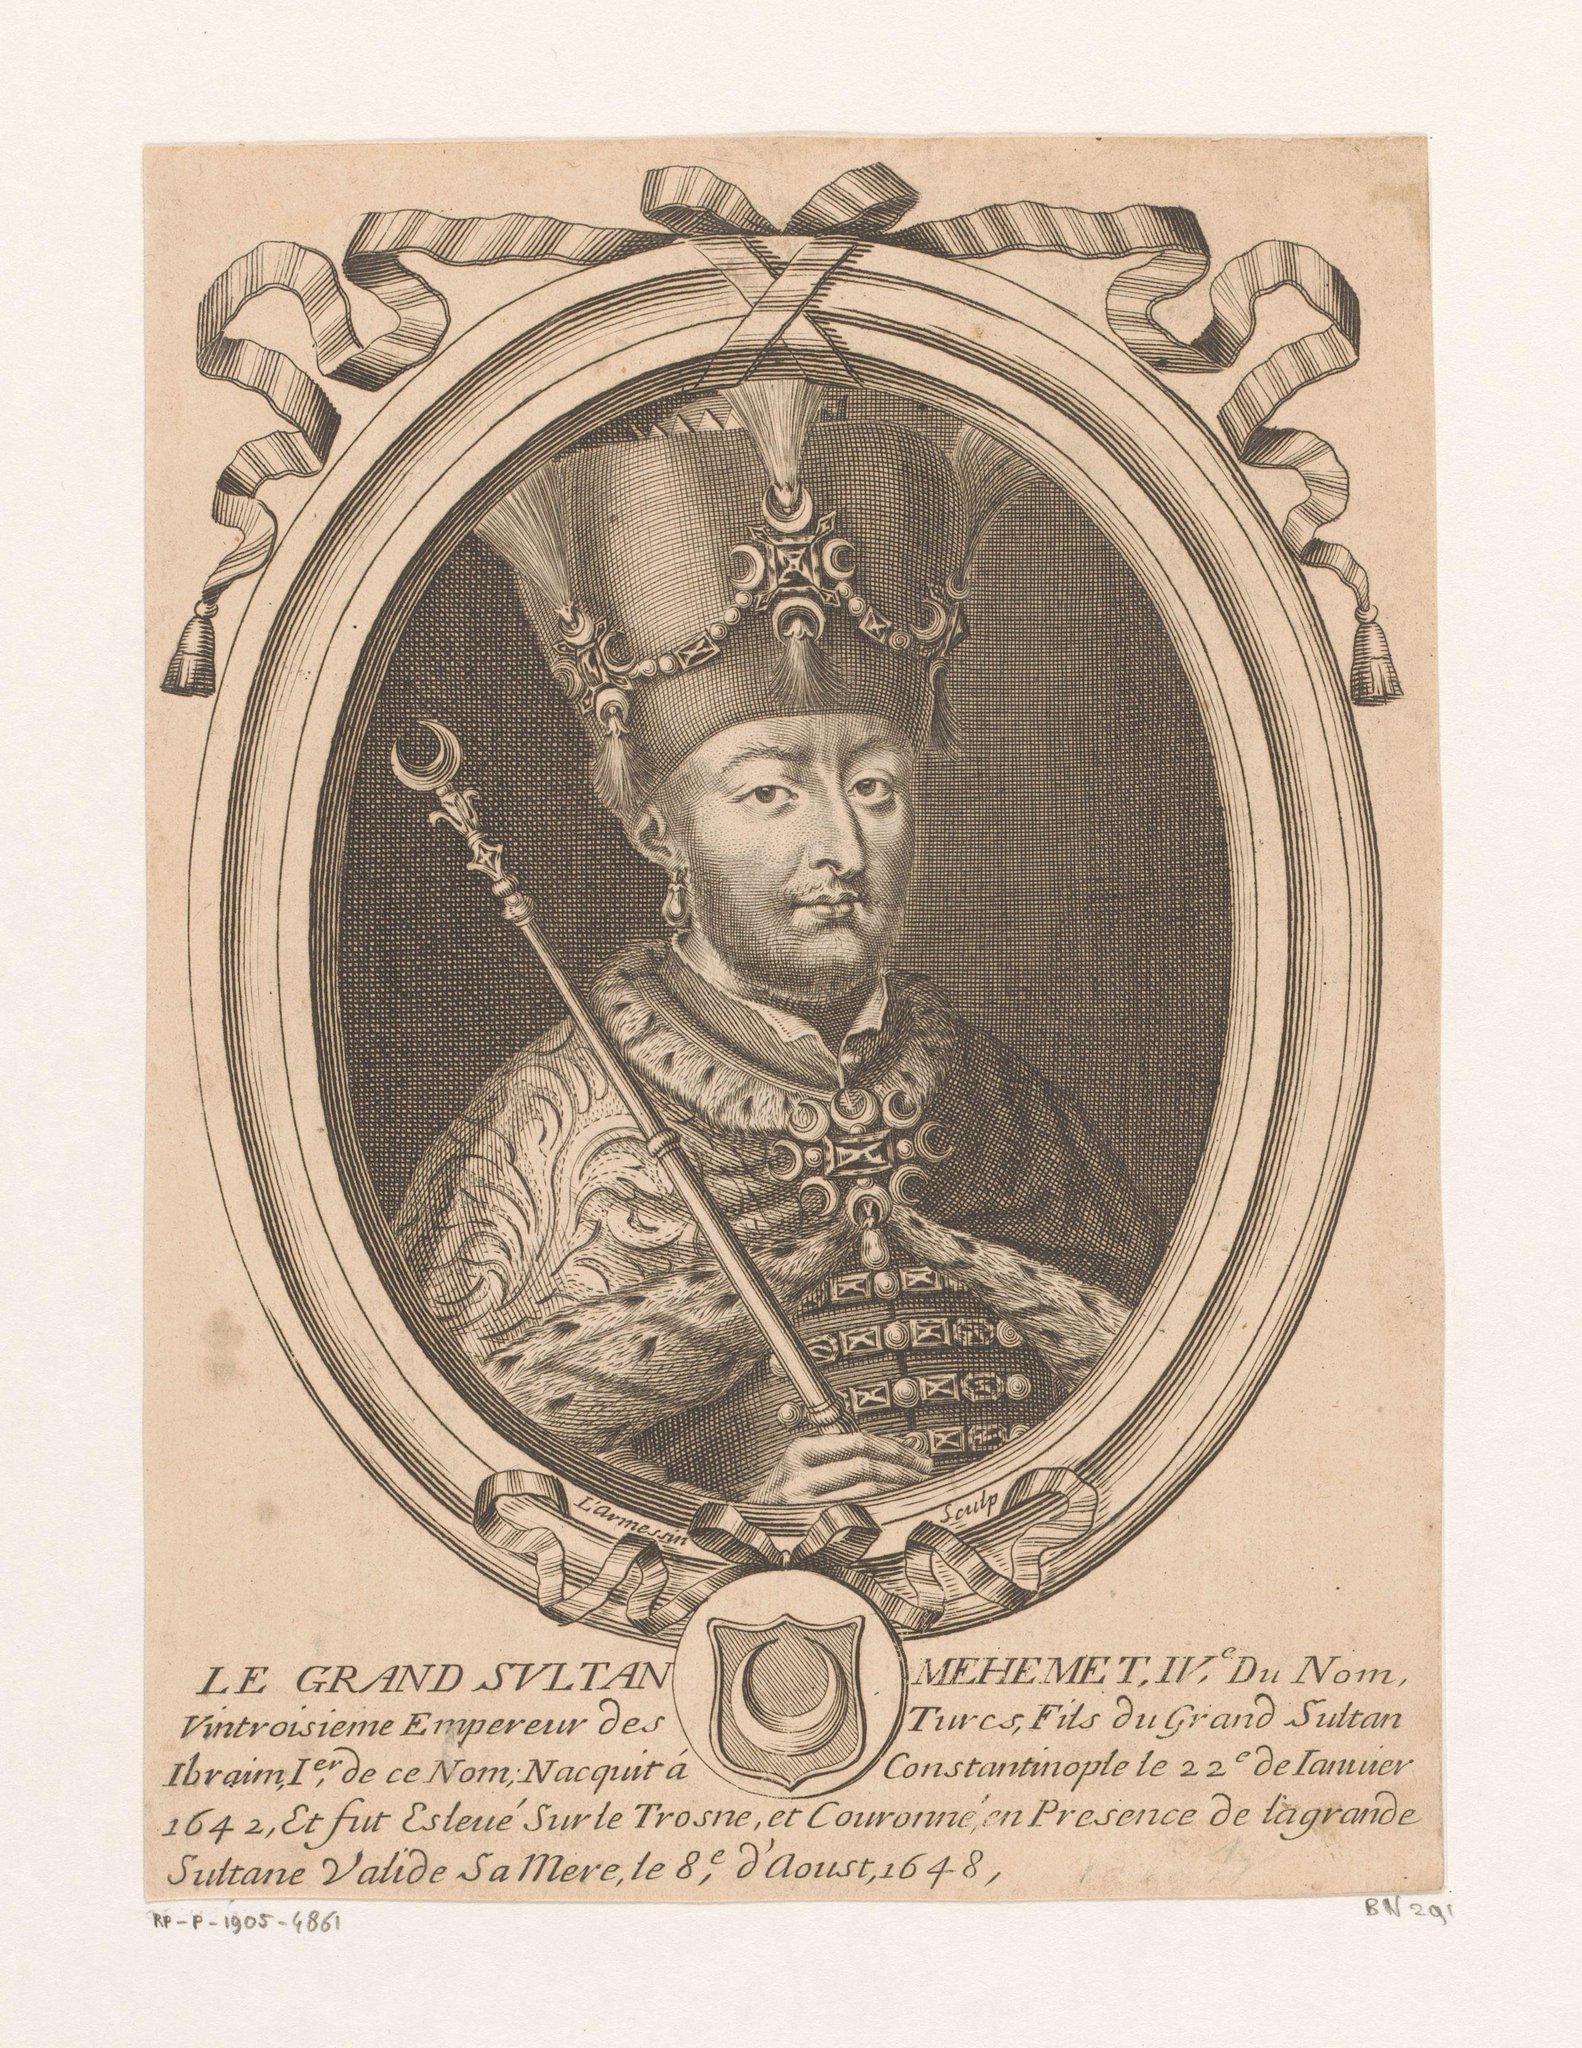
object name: print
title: Portretten van prominente figuren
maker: nicolas de larmessin (i)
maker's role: print maker, publisher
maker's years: 1632-1694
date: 1642-1694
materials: paper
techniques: engraving, etching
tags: historical persons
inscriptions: collector's mark: Lugt 2228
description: Maakt deel uit van een grootschalige serie met portretten van prominente figuren. Binnen de serie bevindt zich een sectie getiteld 'Les Augustes Représentations De tous les Roys De France depuis Pharamond Iusqu'à Louys XIIII'. De serie werd respectievelijk uitgegeven door Pierre Bertrand, door zijn weduwe en door De Larmessin zelf.